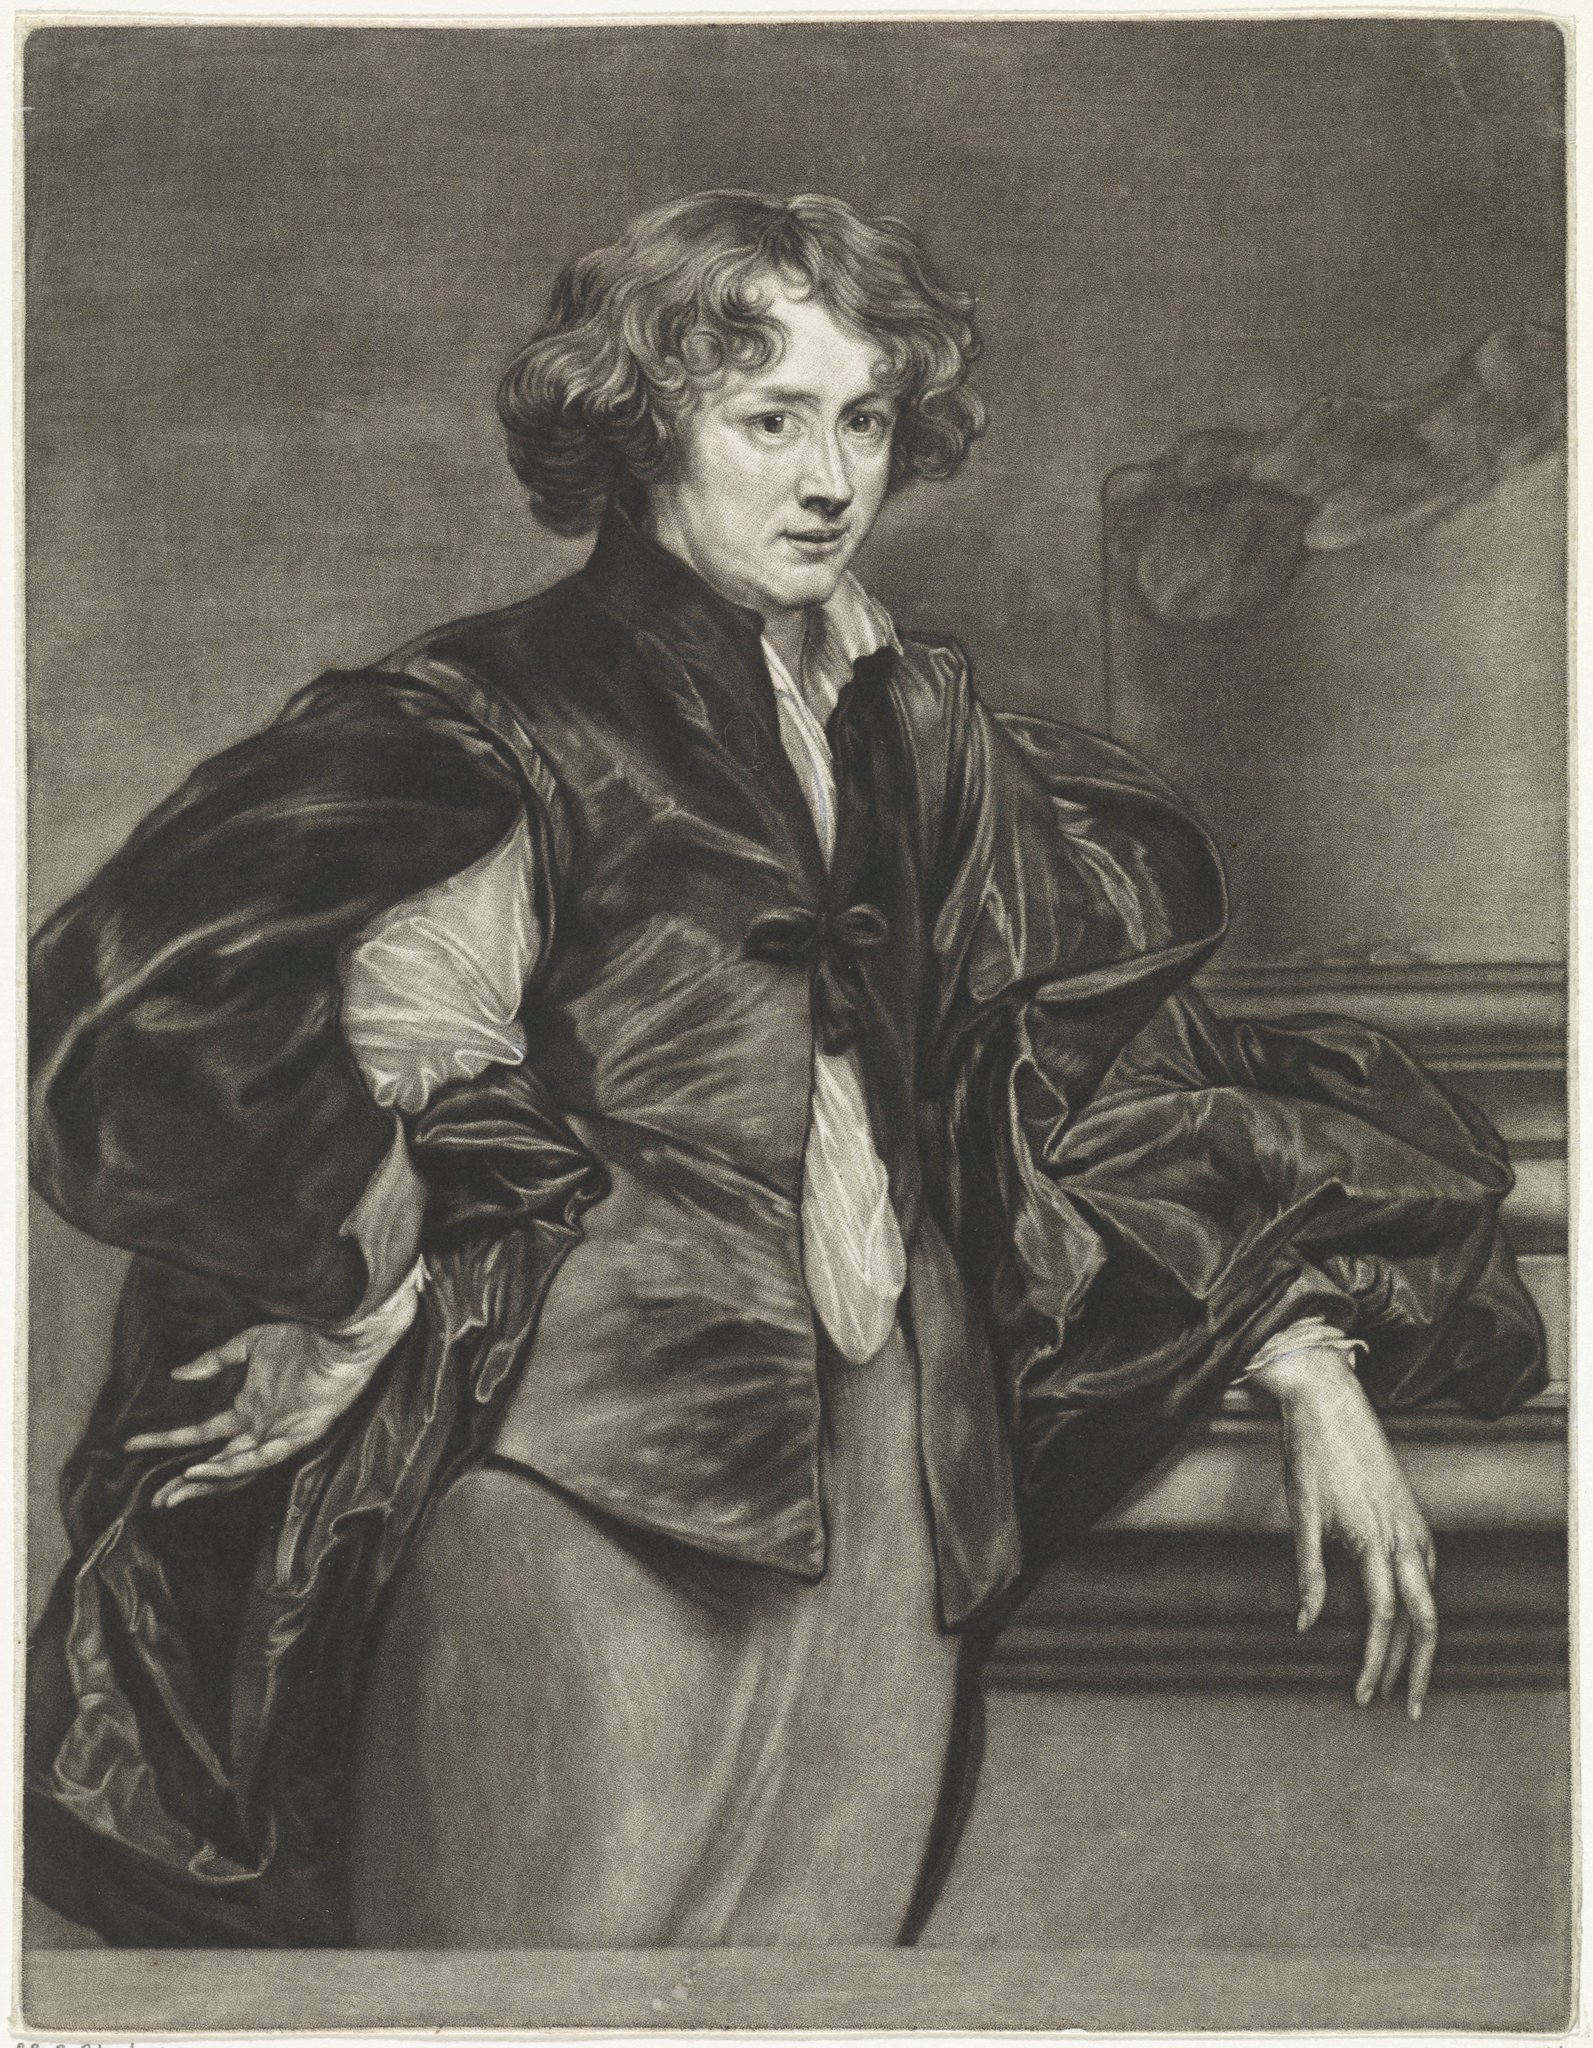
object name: print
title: Zelfportret van Anthony van Dyck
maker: jan van der bruggen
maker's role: draughtsman, print maker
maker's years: 1649-1709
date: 1682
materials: paper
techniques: mezzotint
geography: paris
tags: antwerp, painter, anthony van dyck, portrait, self-portrait of painter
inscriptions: collector's mark: Lugt 240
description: Zelfportret van de Vlaamse schilder Anthony van Dyck.